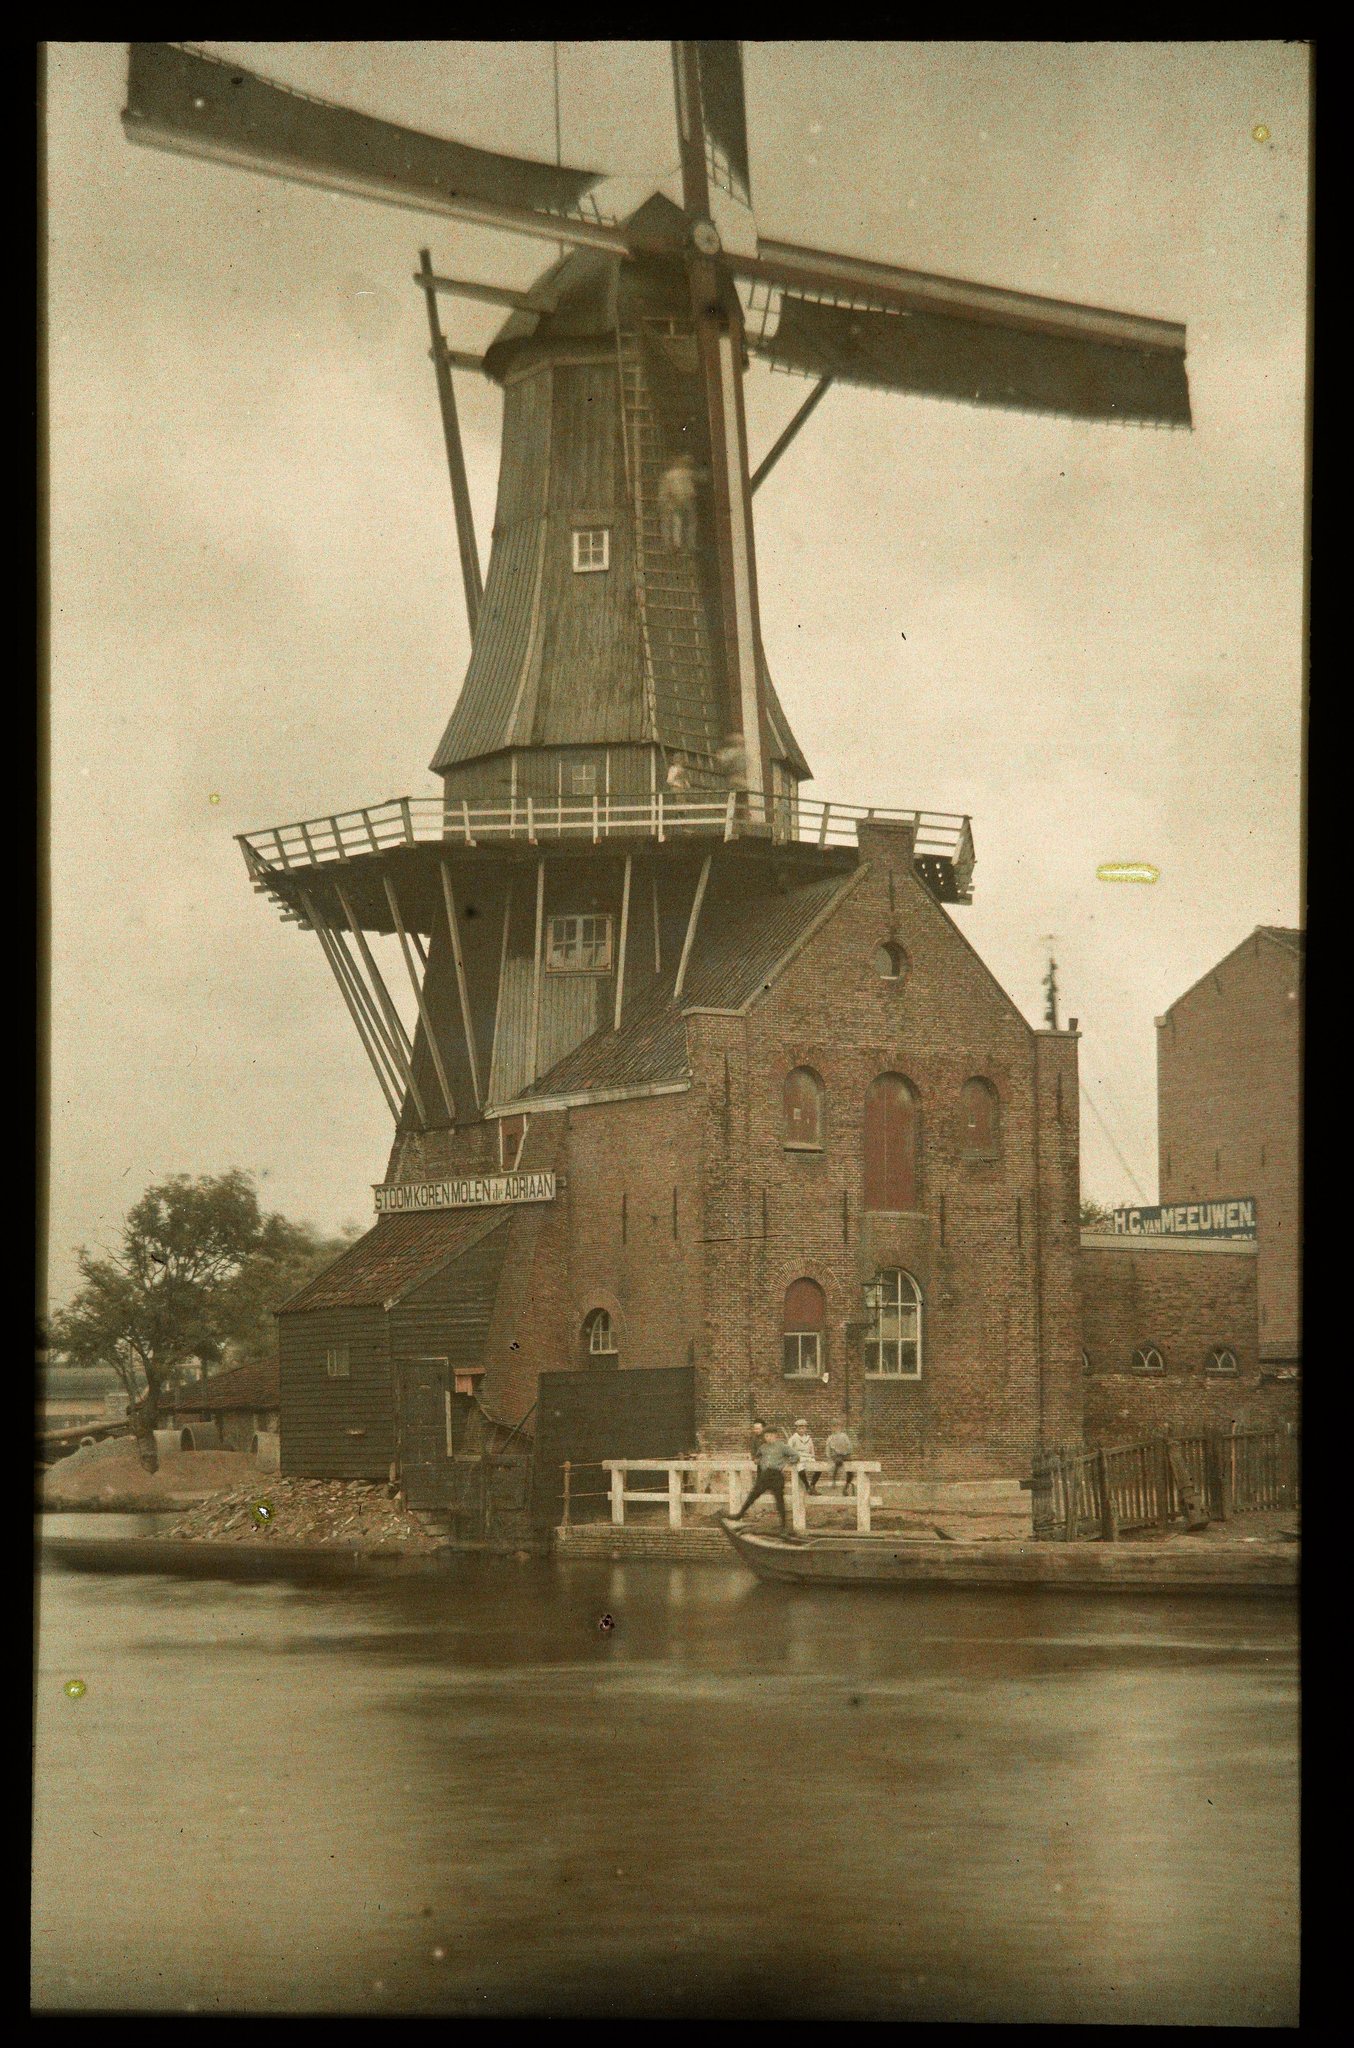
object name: photograph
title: Stoomkorenmolen De Adriaan aan het Spaarne, Haarlem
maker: Anonymous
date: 1912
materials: glass, paper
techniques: autochrome process